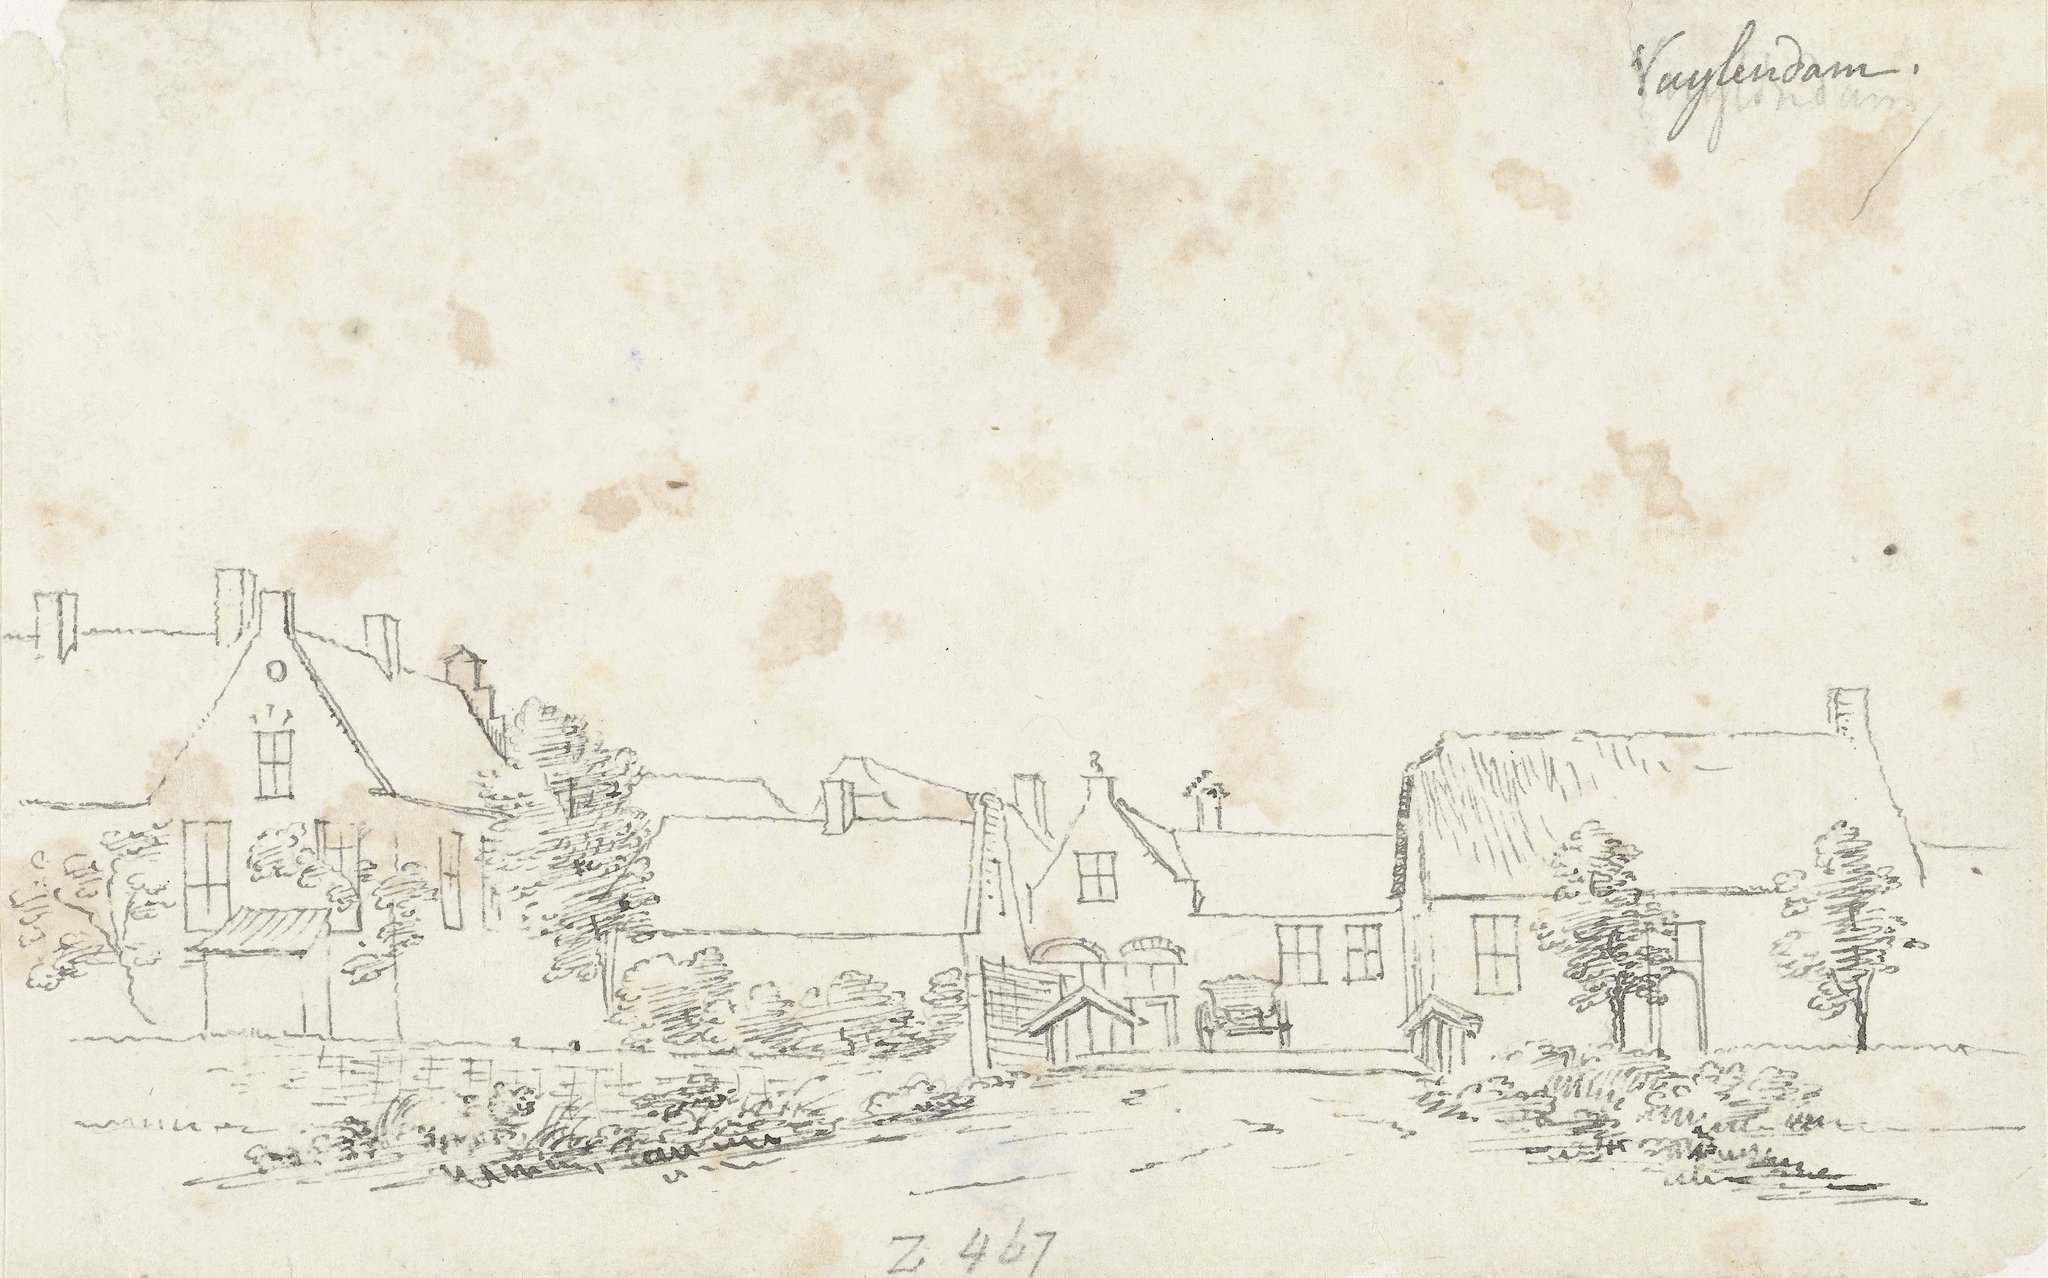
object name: drawing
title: Het dorp Vuilendam bij Molenaarsgraaf in de Alblasserwaard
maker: cornelis pronk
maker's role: draughtsman, painter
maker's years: 1691-1759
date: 1720-1740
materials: ink, paper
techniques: pen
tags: prospect of village, silhouette of village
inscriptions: inscription: ‘Vuylendam’